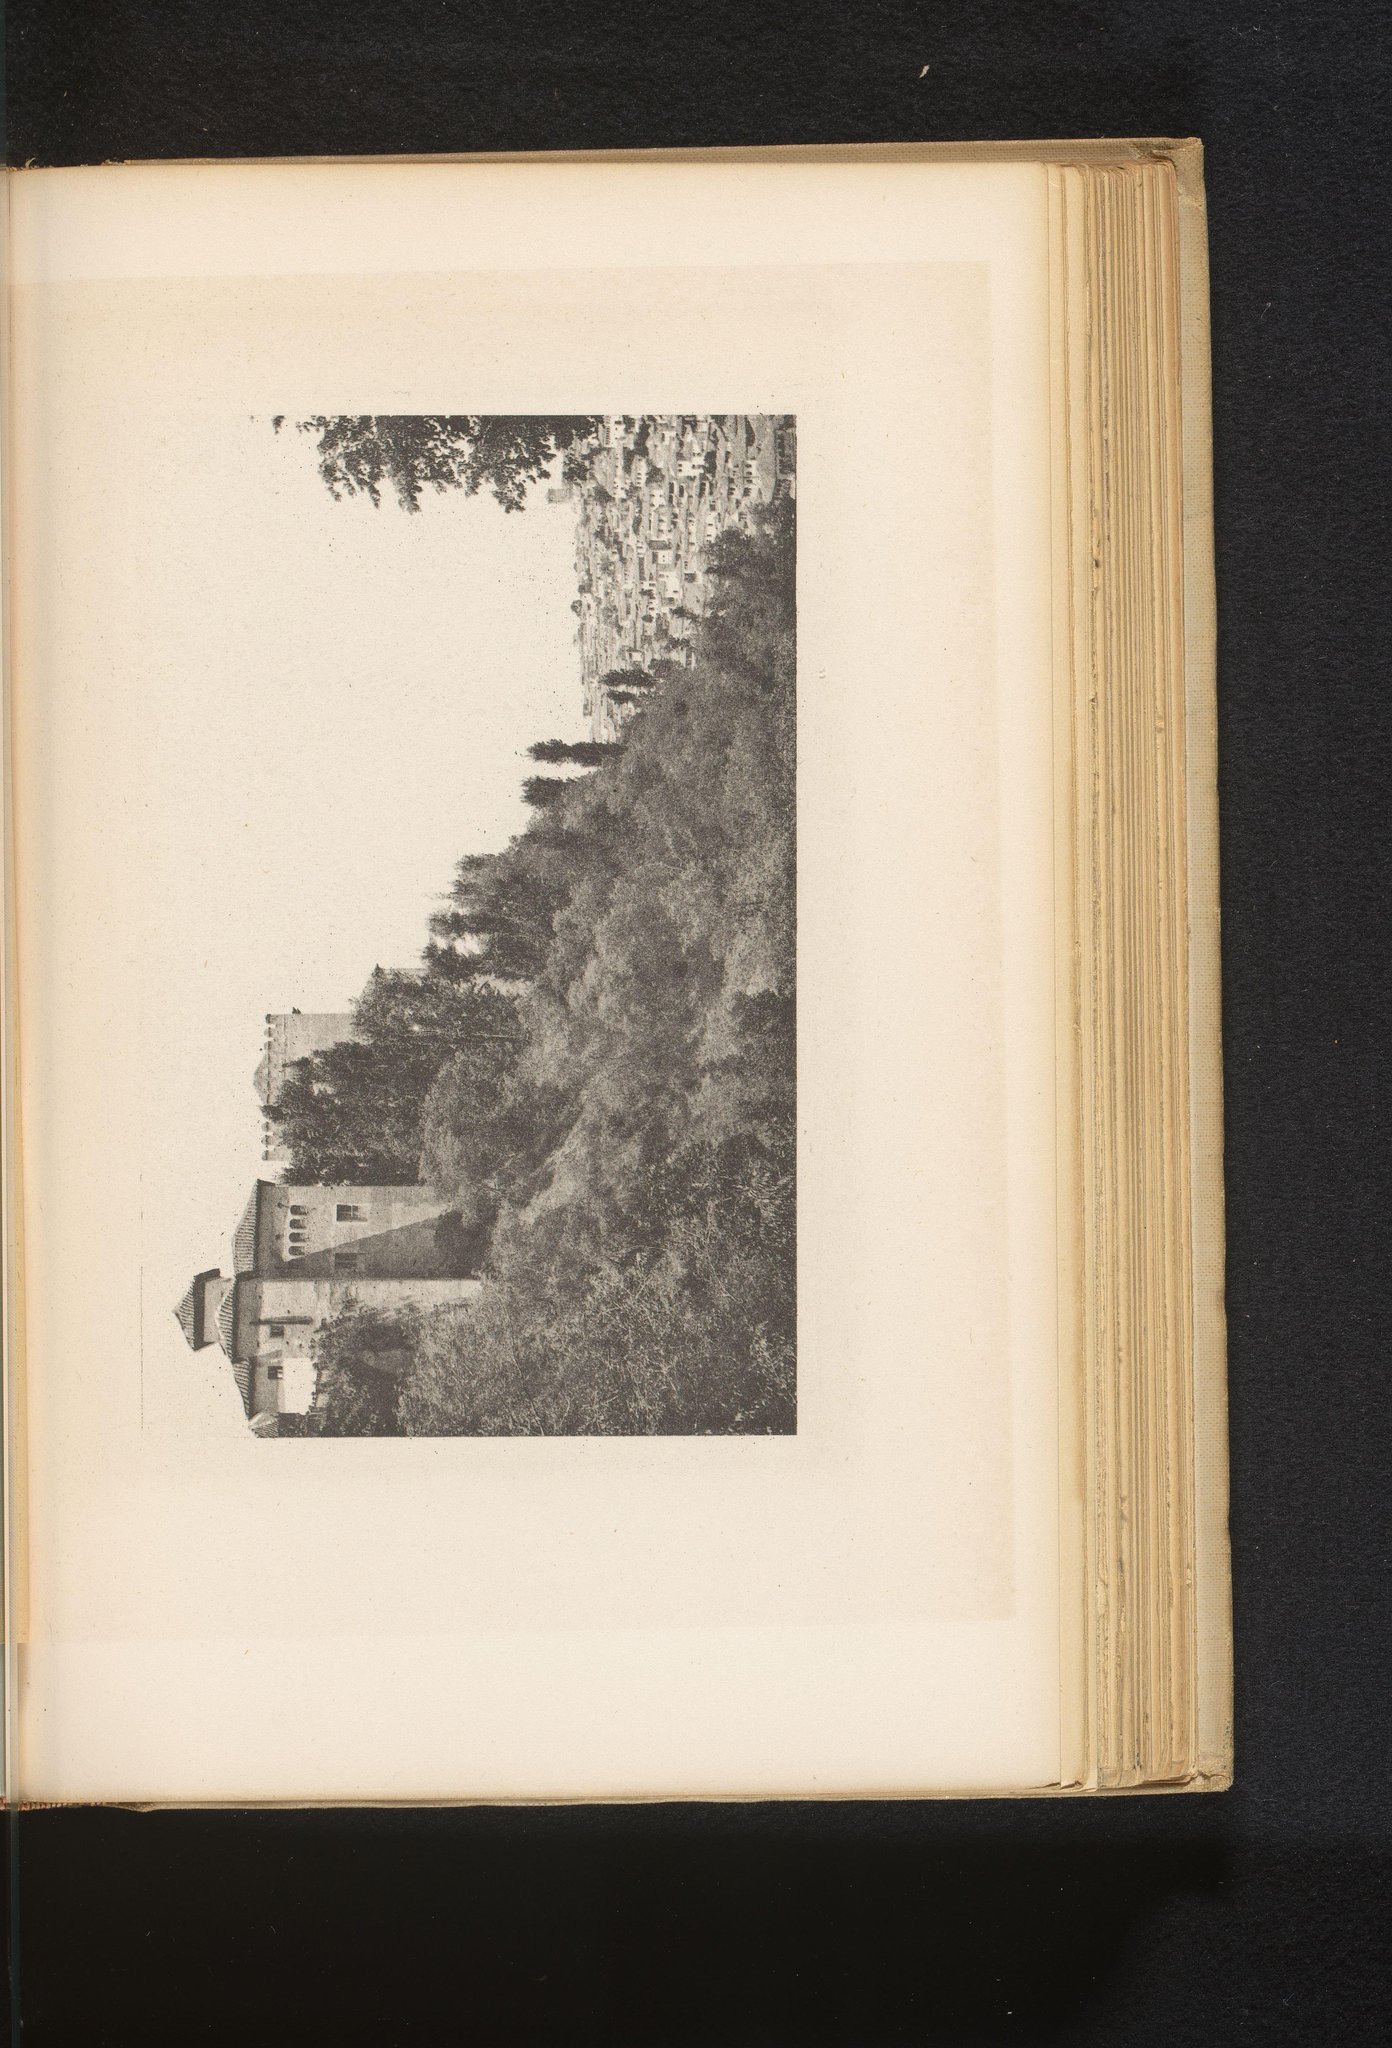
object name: page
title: Gezicht op de Torre del Mihrab in het Alhambra en rechts een stuk van Granada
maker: Anonymous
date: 1884-1894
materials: paper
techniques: photoaquatint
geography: granada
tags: tower, clock tower ~ monumental adornment, city-view in general; 'veduta'